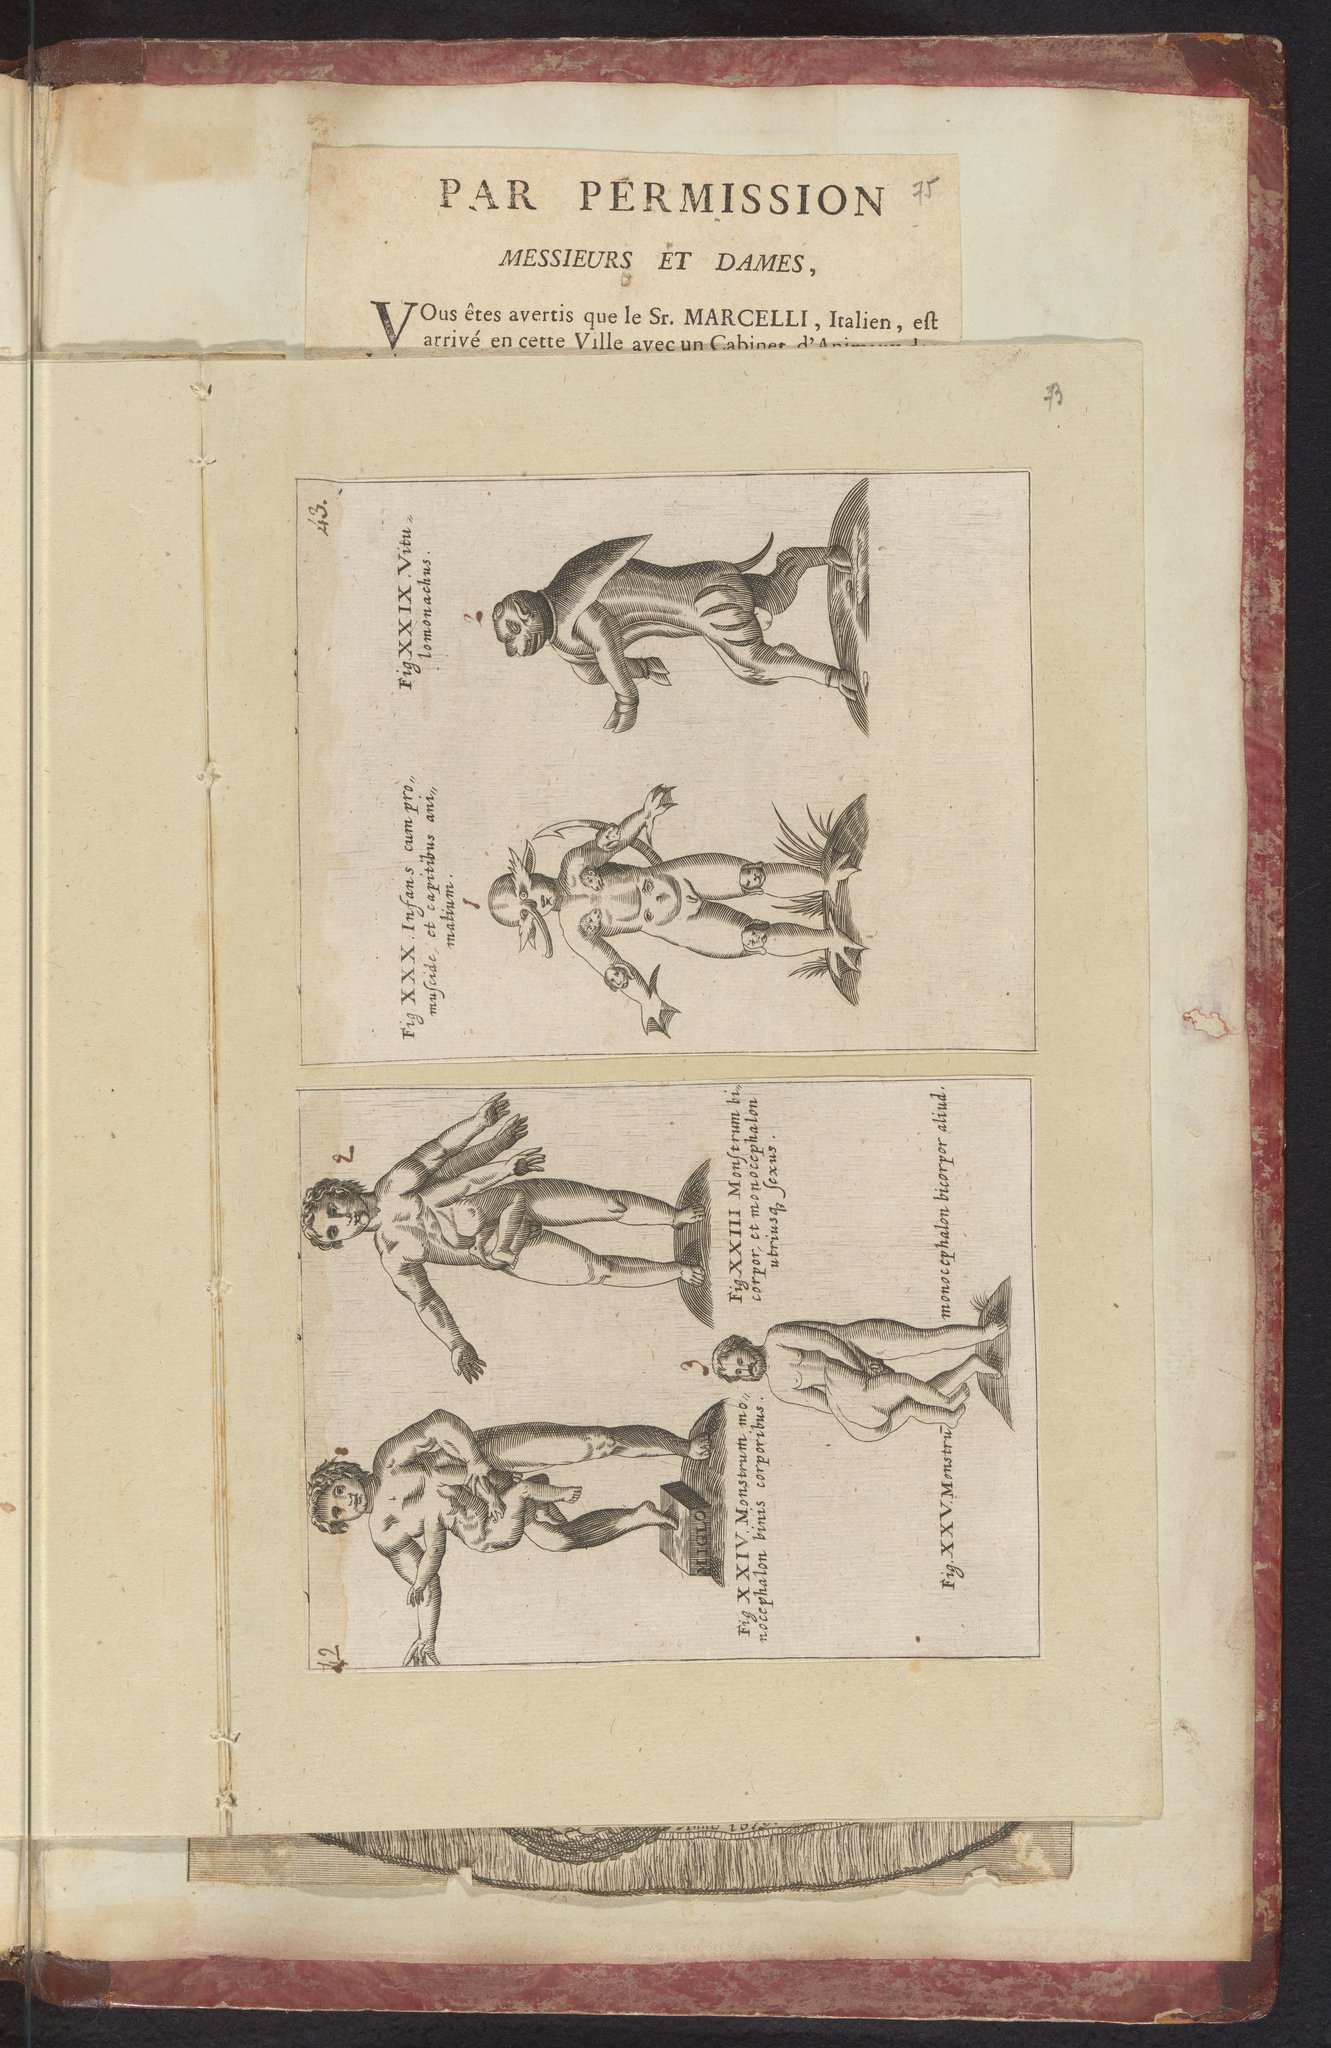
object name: print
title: Misvormde menselijke figuren en dieren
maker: Anonymous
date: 1665-1667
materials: paper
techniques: engraving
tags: monsters with parts in greater number than normal, monsters of mixed human and animal shape; 'mostri' (ripa)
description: Twee ingeplakte prenten met misvormde menselijke figuren en dieren. Links drie misvormde mensen (Fig. XXIII-XXV). Linksboven genummerd: 42. Rechts een misvormd mens en een misvormd dier (Fig. XXIX-XXX). Rechtsboven genummerd: 43. Op een kleiner formaat blad papier. Onderdeel van het zevende album met tekeningen van reptielen, amfibieën en natuurhistorische ensembles. Het zevende van twaalf albums met aquarellen van dieren, vogels en planten bekend rond 1600, gemaakt in opdracht van keizer Rudolf II. Met toelichting in Nederlands, Latijn en Frans.